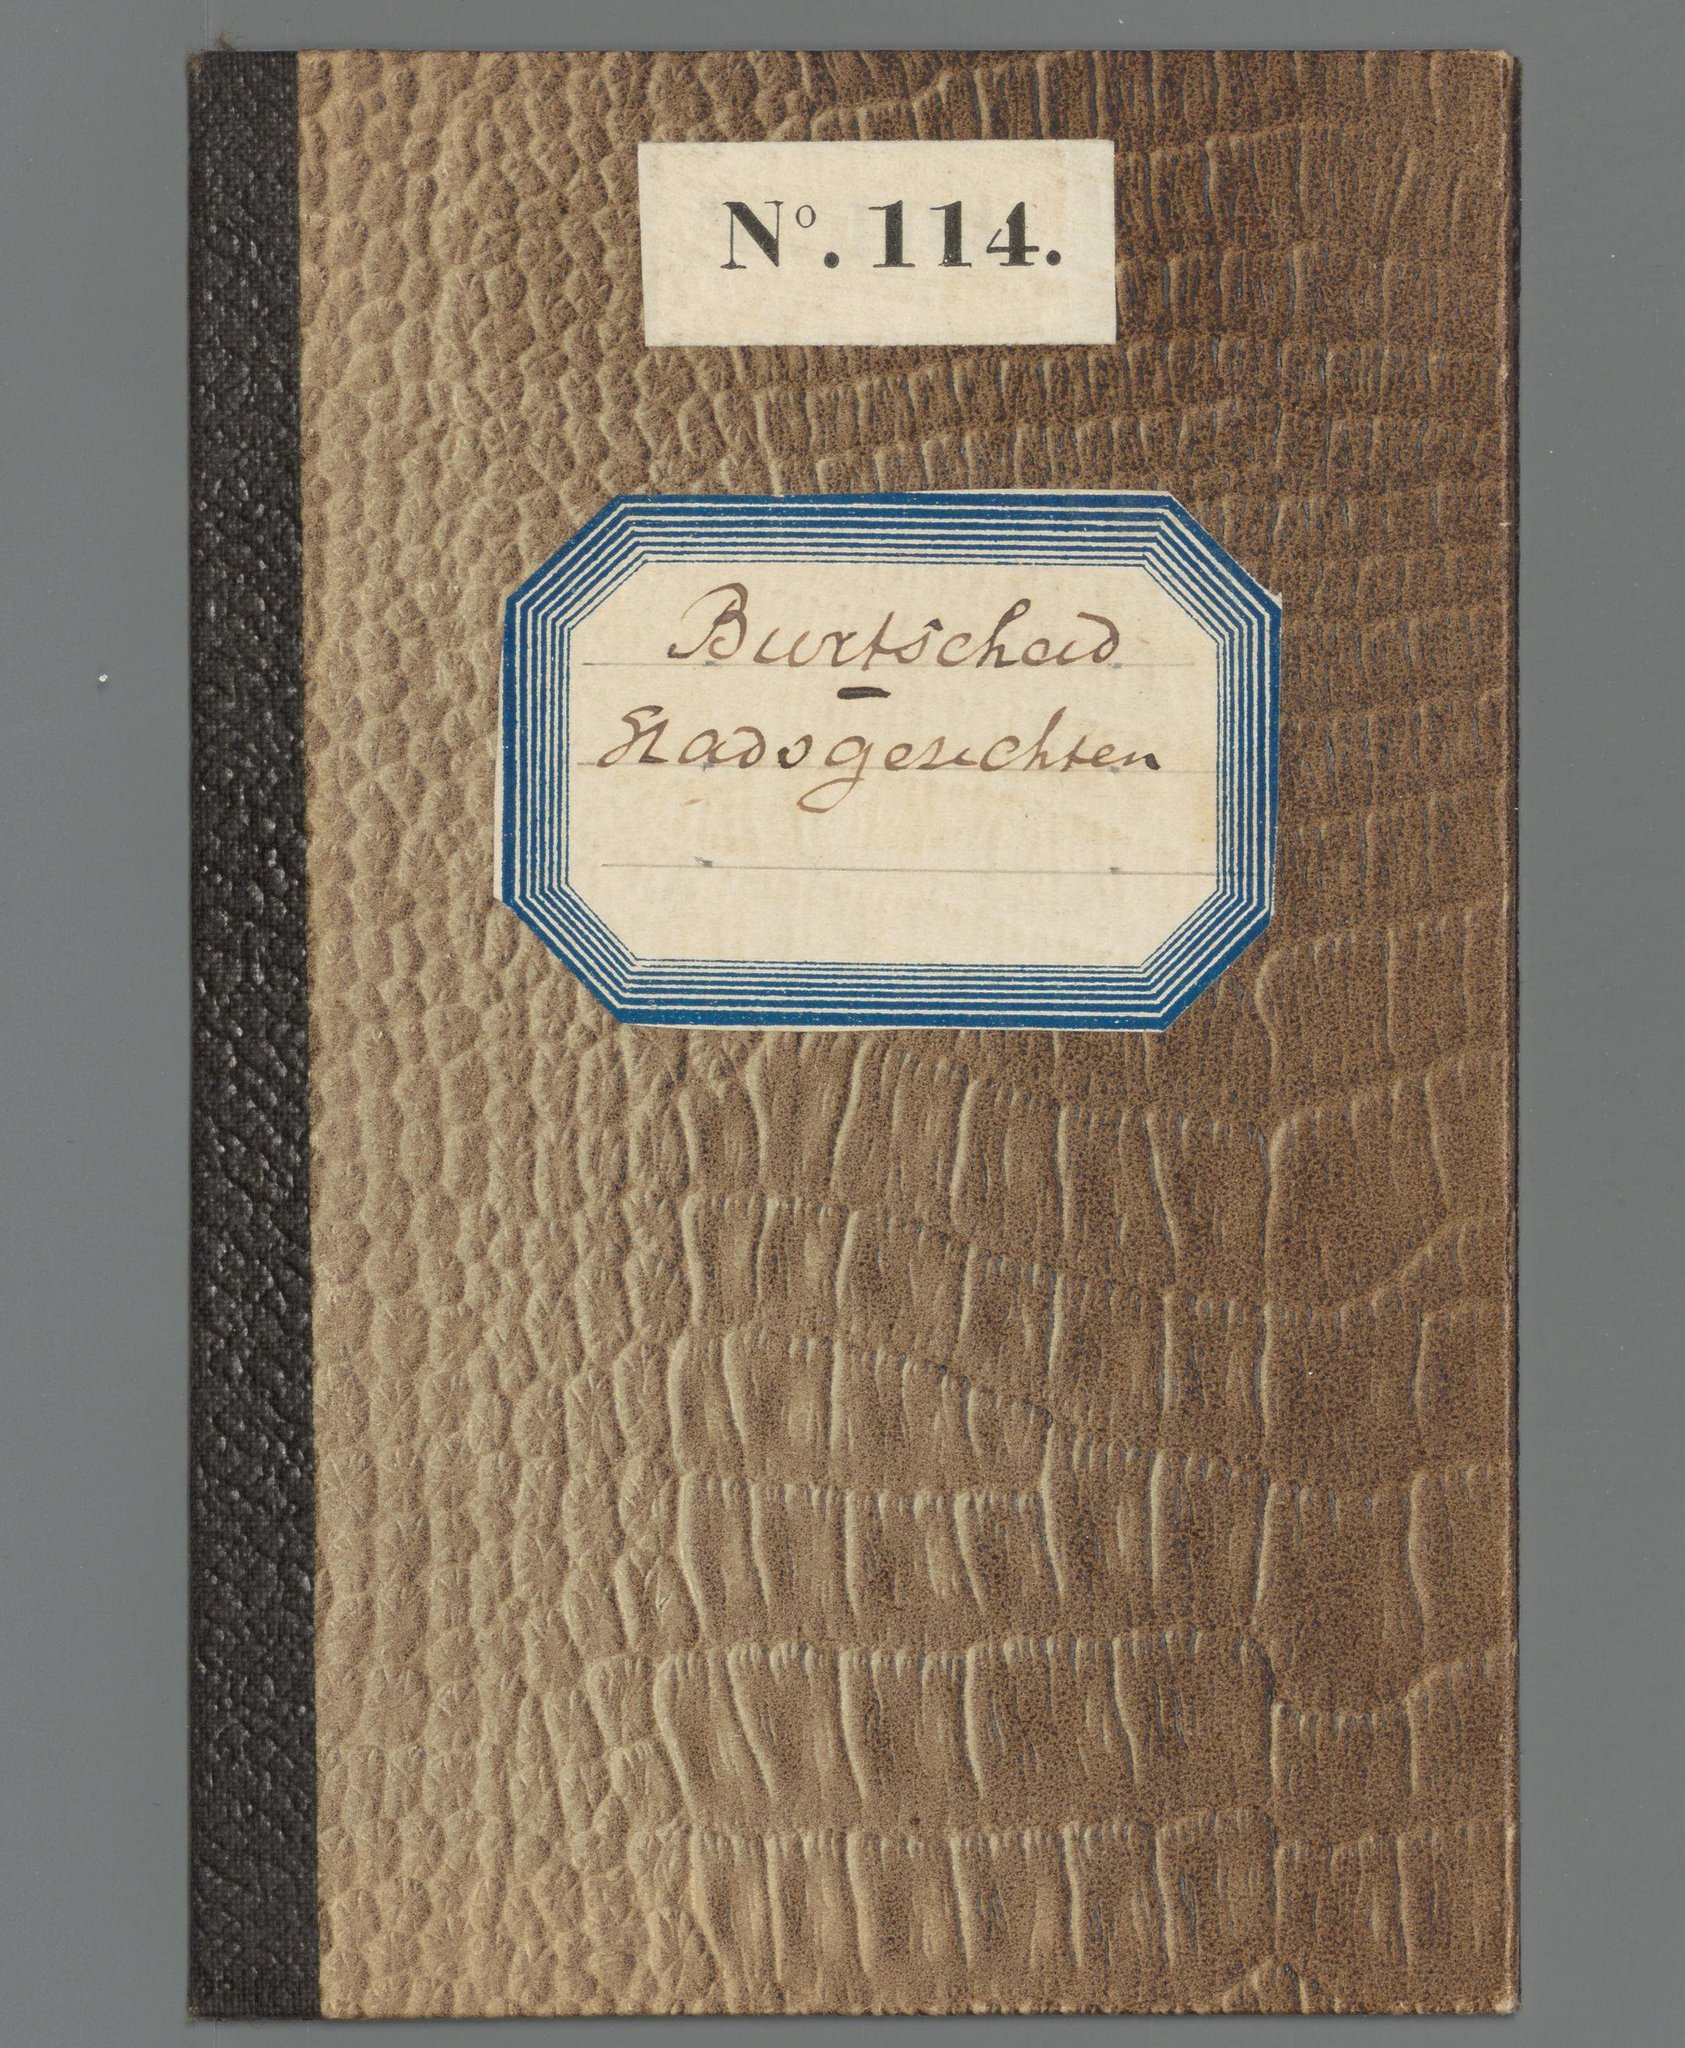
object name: wrapper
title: Burtscheid. Stadsgezichten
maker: Anonymous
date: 1900-1950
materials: cardboard, paper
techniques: lithograph, writing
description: In de omslag zit een kaart ingestoken met daarop een korte beschrijving van de inhoud.